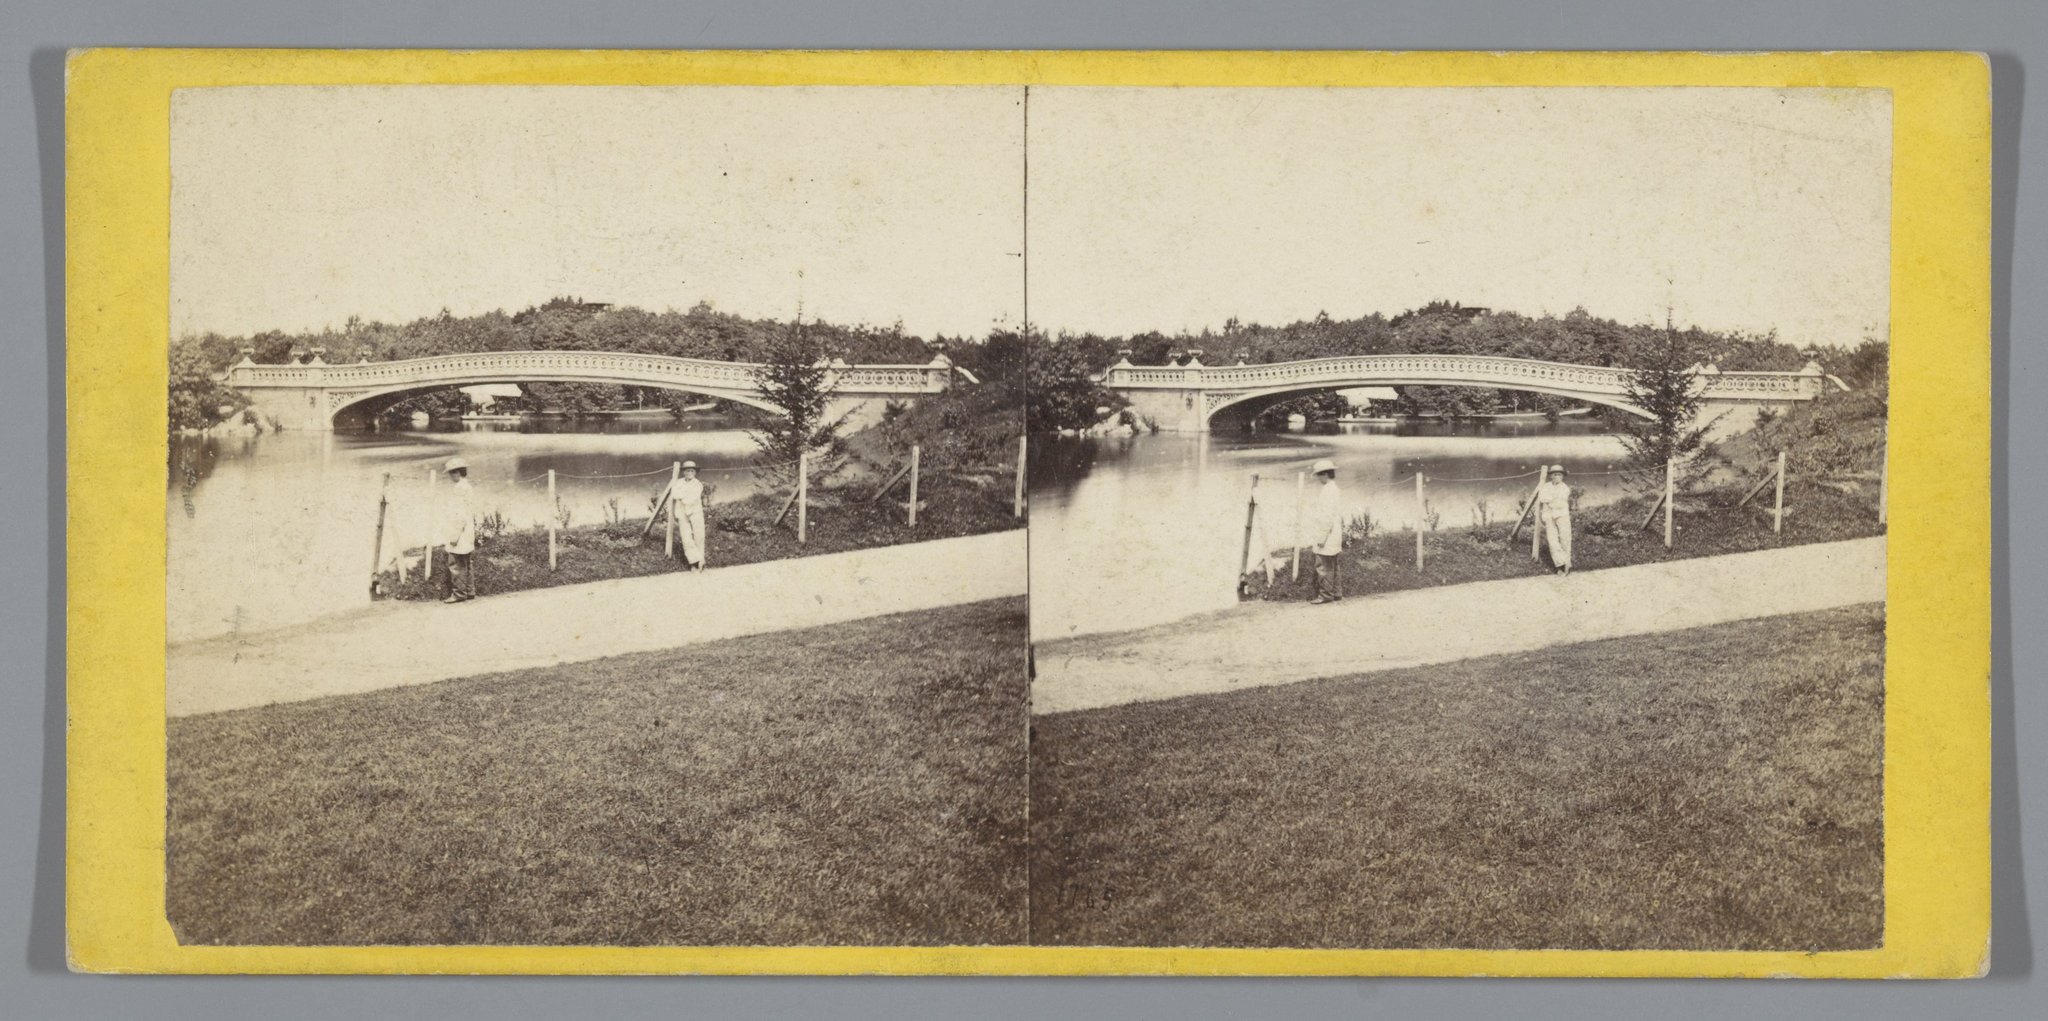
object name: stereograph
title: A visit to the "Central Park" in the summer of 1863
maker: thomas c. roche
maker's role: fotograaf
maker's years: 1826-1895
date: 1863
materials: cardboard, paper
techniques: albumen print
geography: new york city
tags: park, bridge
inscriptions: number: ‘No. 1164’, : ‘Board of Commissioners of the Central Park, 1863 (...)’, number: ‘7’